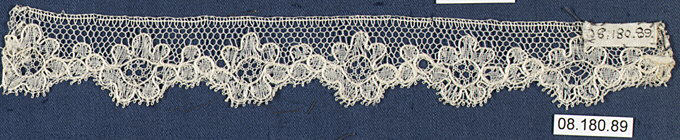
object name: fragment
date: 1801-1900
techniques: lace